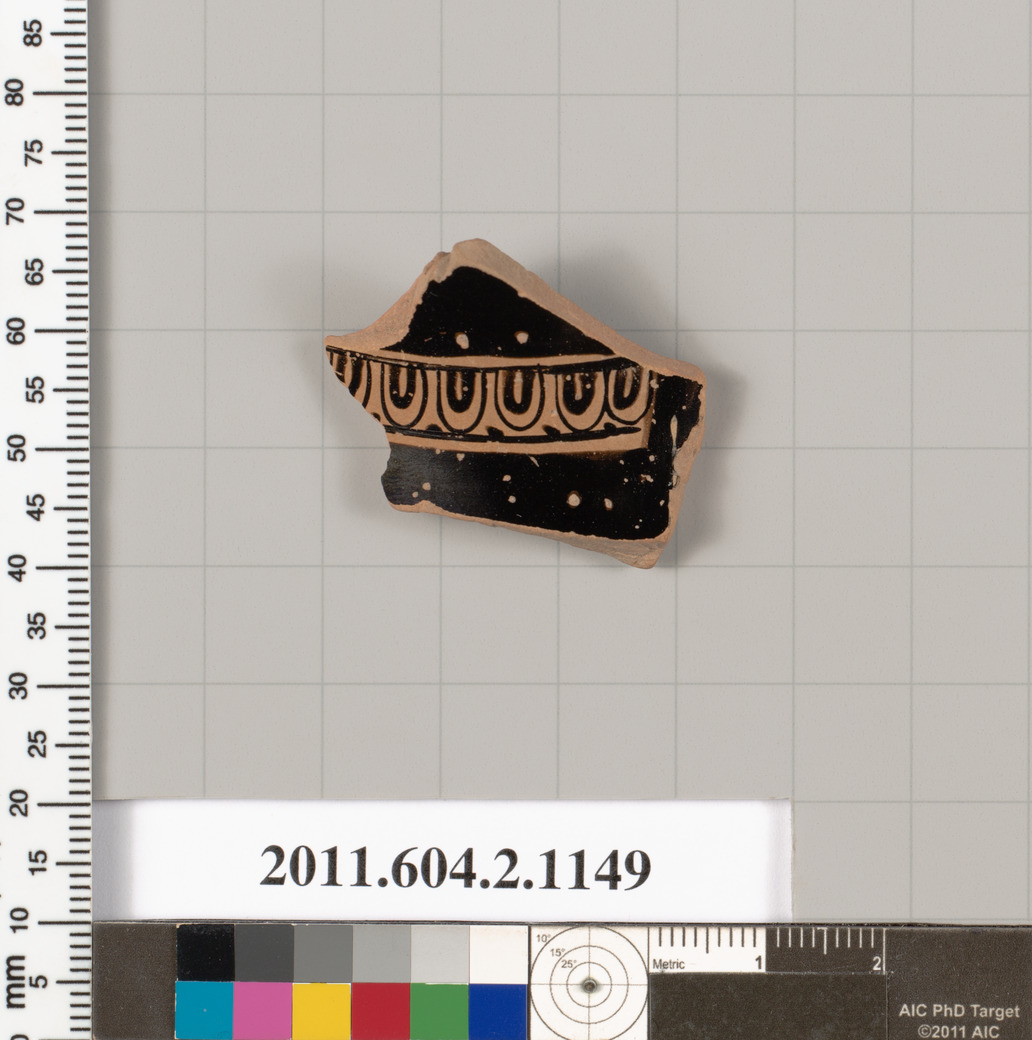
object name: chou fragment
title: Terracotta fragment of an oinochoe: chous (jug)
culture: greek, attic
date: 425-401 BCE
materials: terracotta